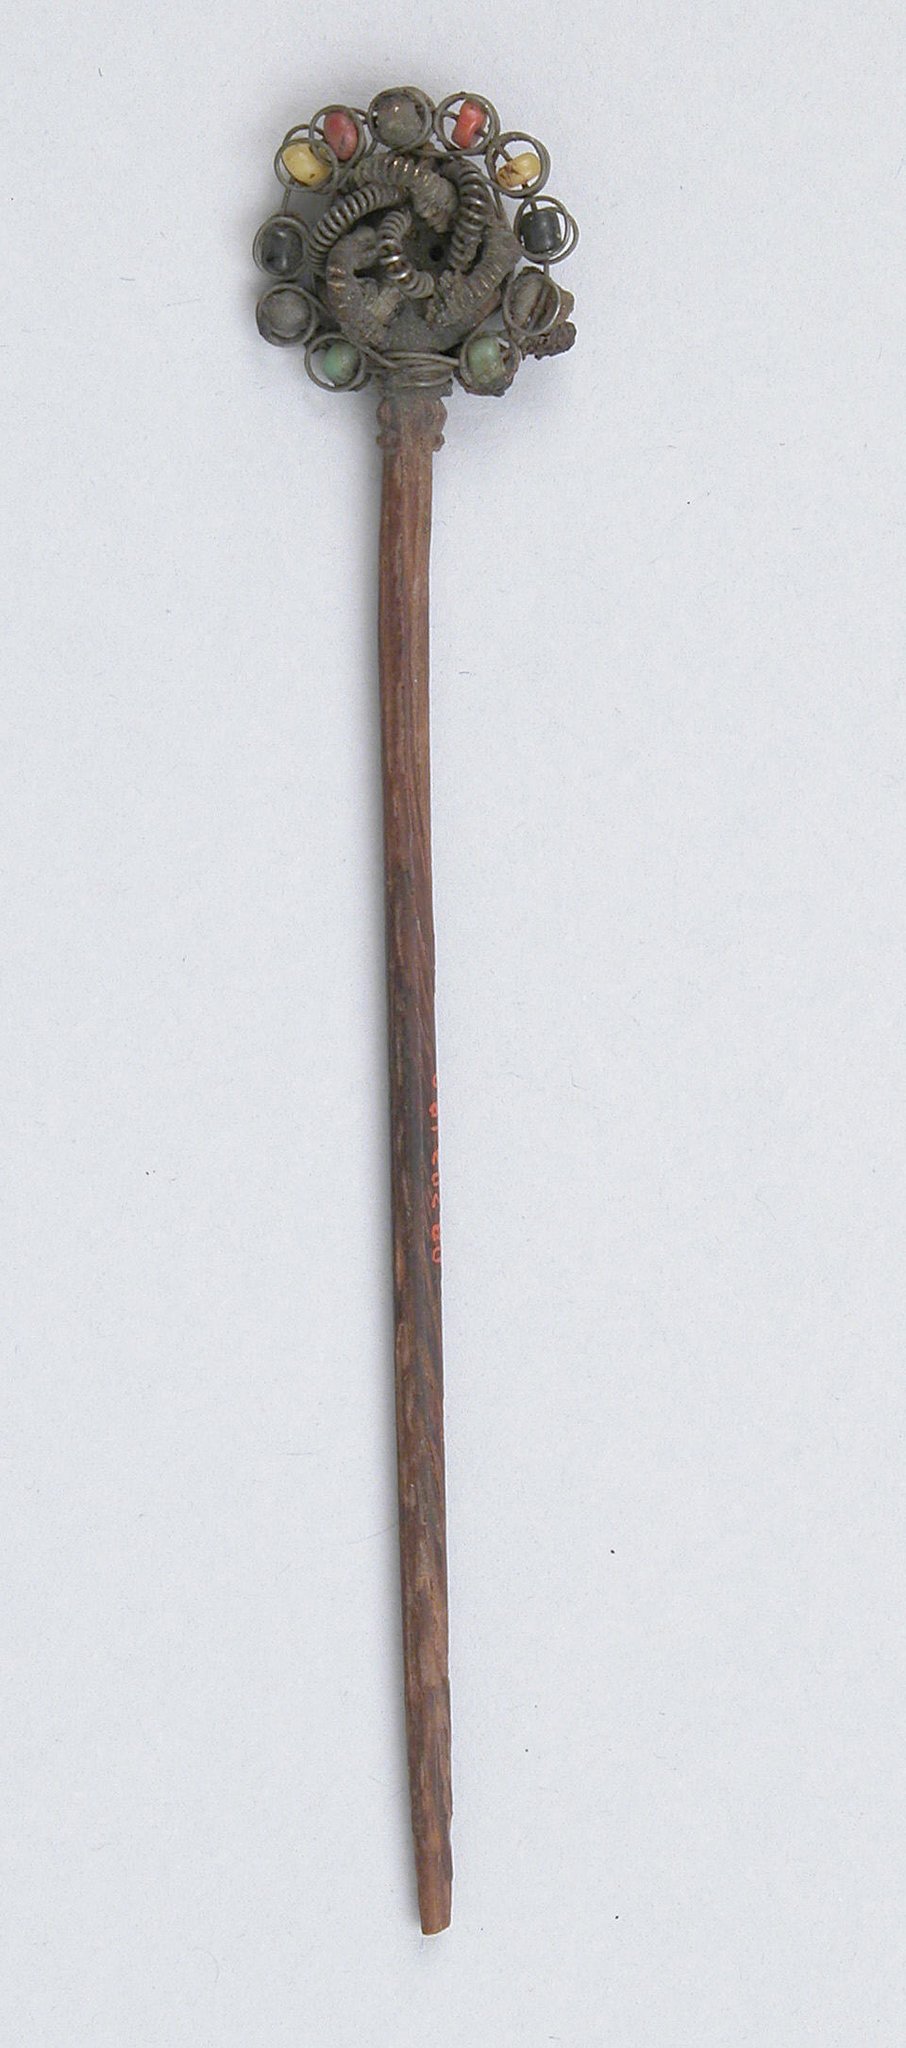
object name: hairpin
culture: coptic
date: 401-600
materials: glass, metal, wood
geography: egypt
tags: pins